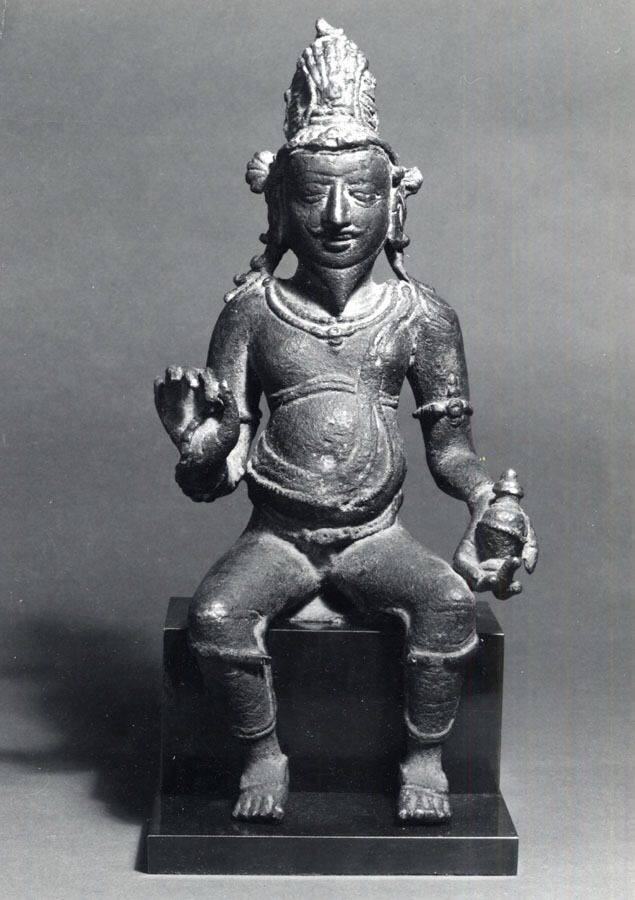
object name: figure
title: Seated Agastya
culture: indonesian, sumatran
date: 701-900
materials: bronze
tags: hinduism